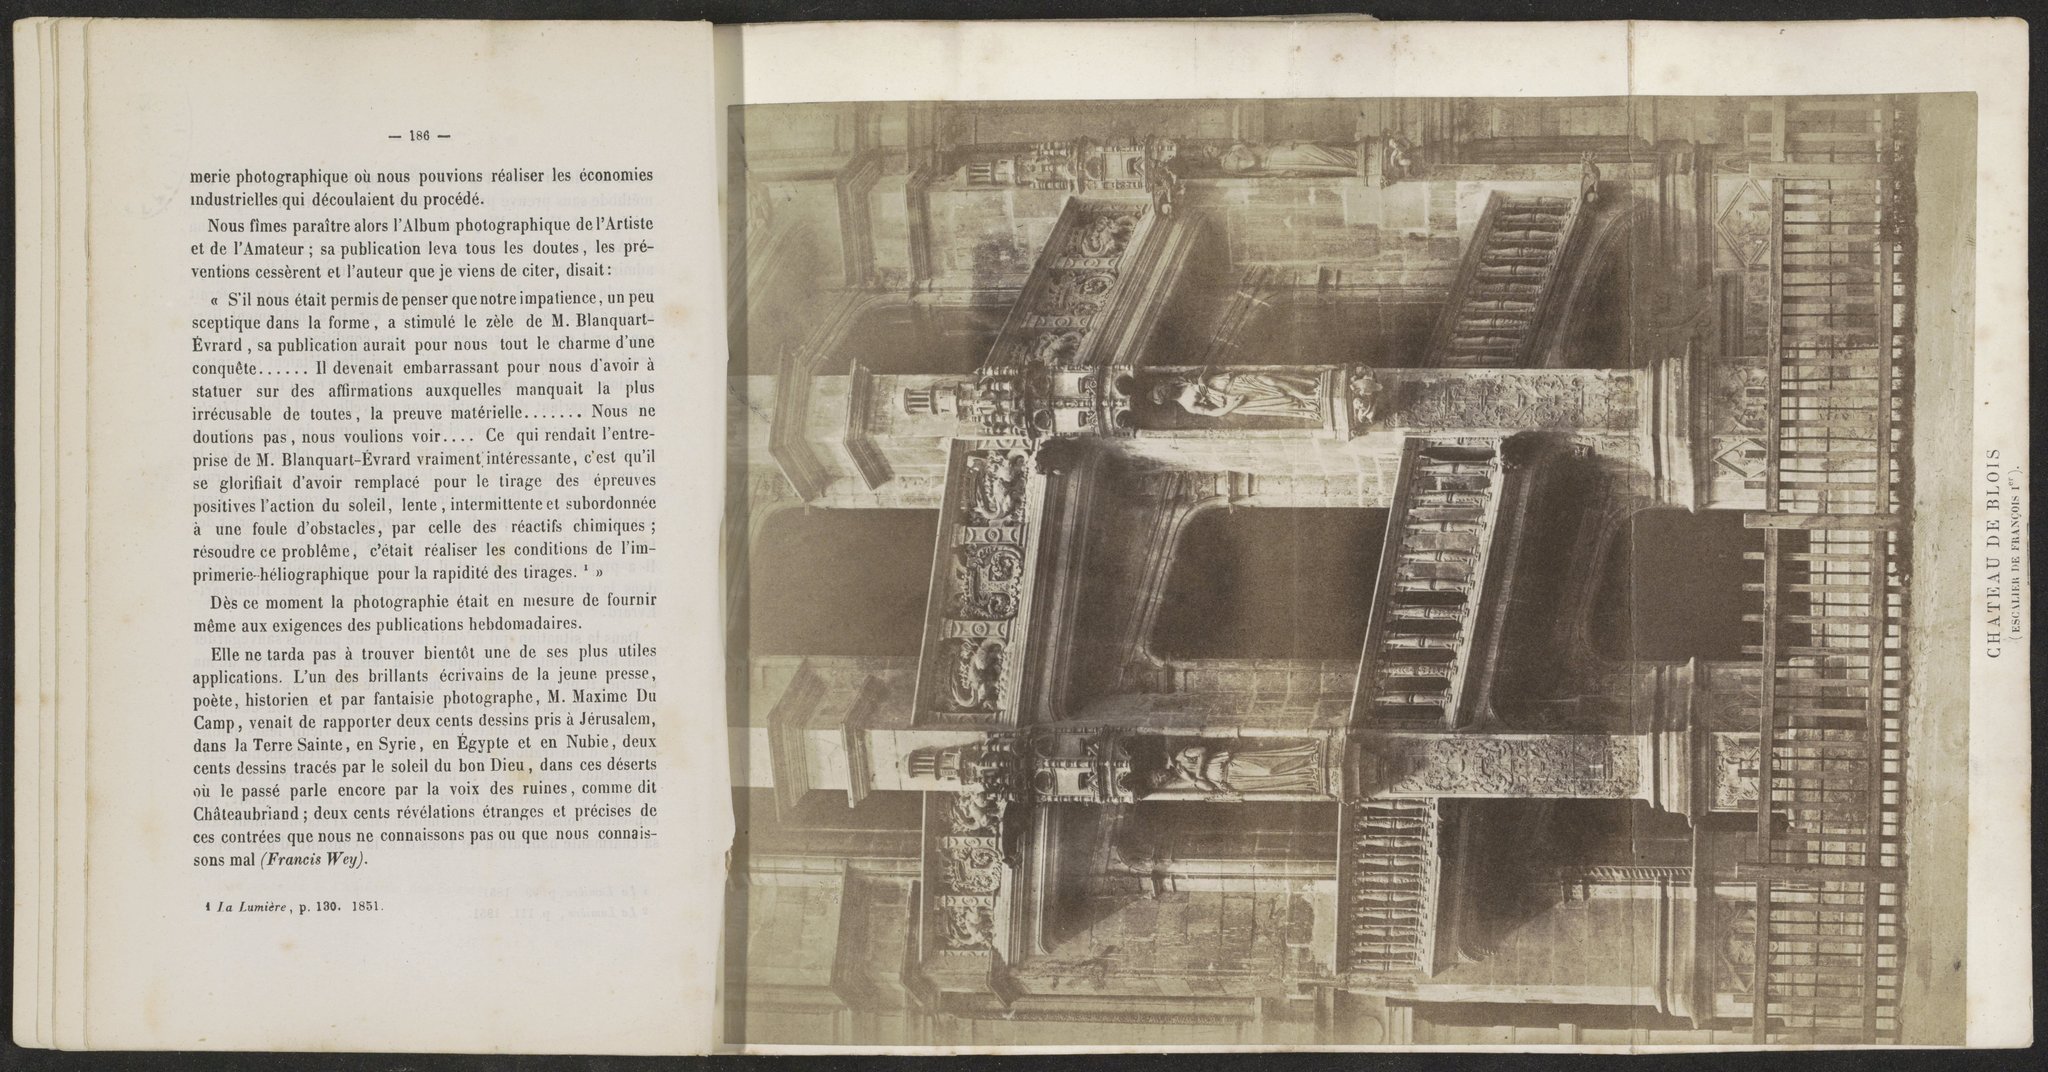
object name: page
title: Chateau de Blois (escalier de François 1er)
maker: Anonymous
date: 1859-1869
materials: photographic support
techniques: salted paper print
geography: blois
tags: staircase